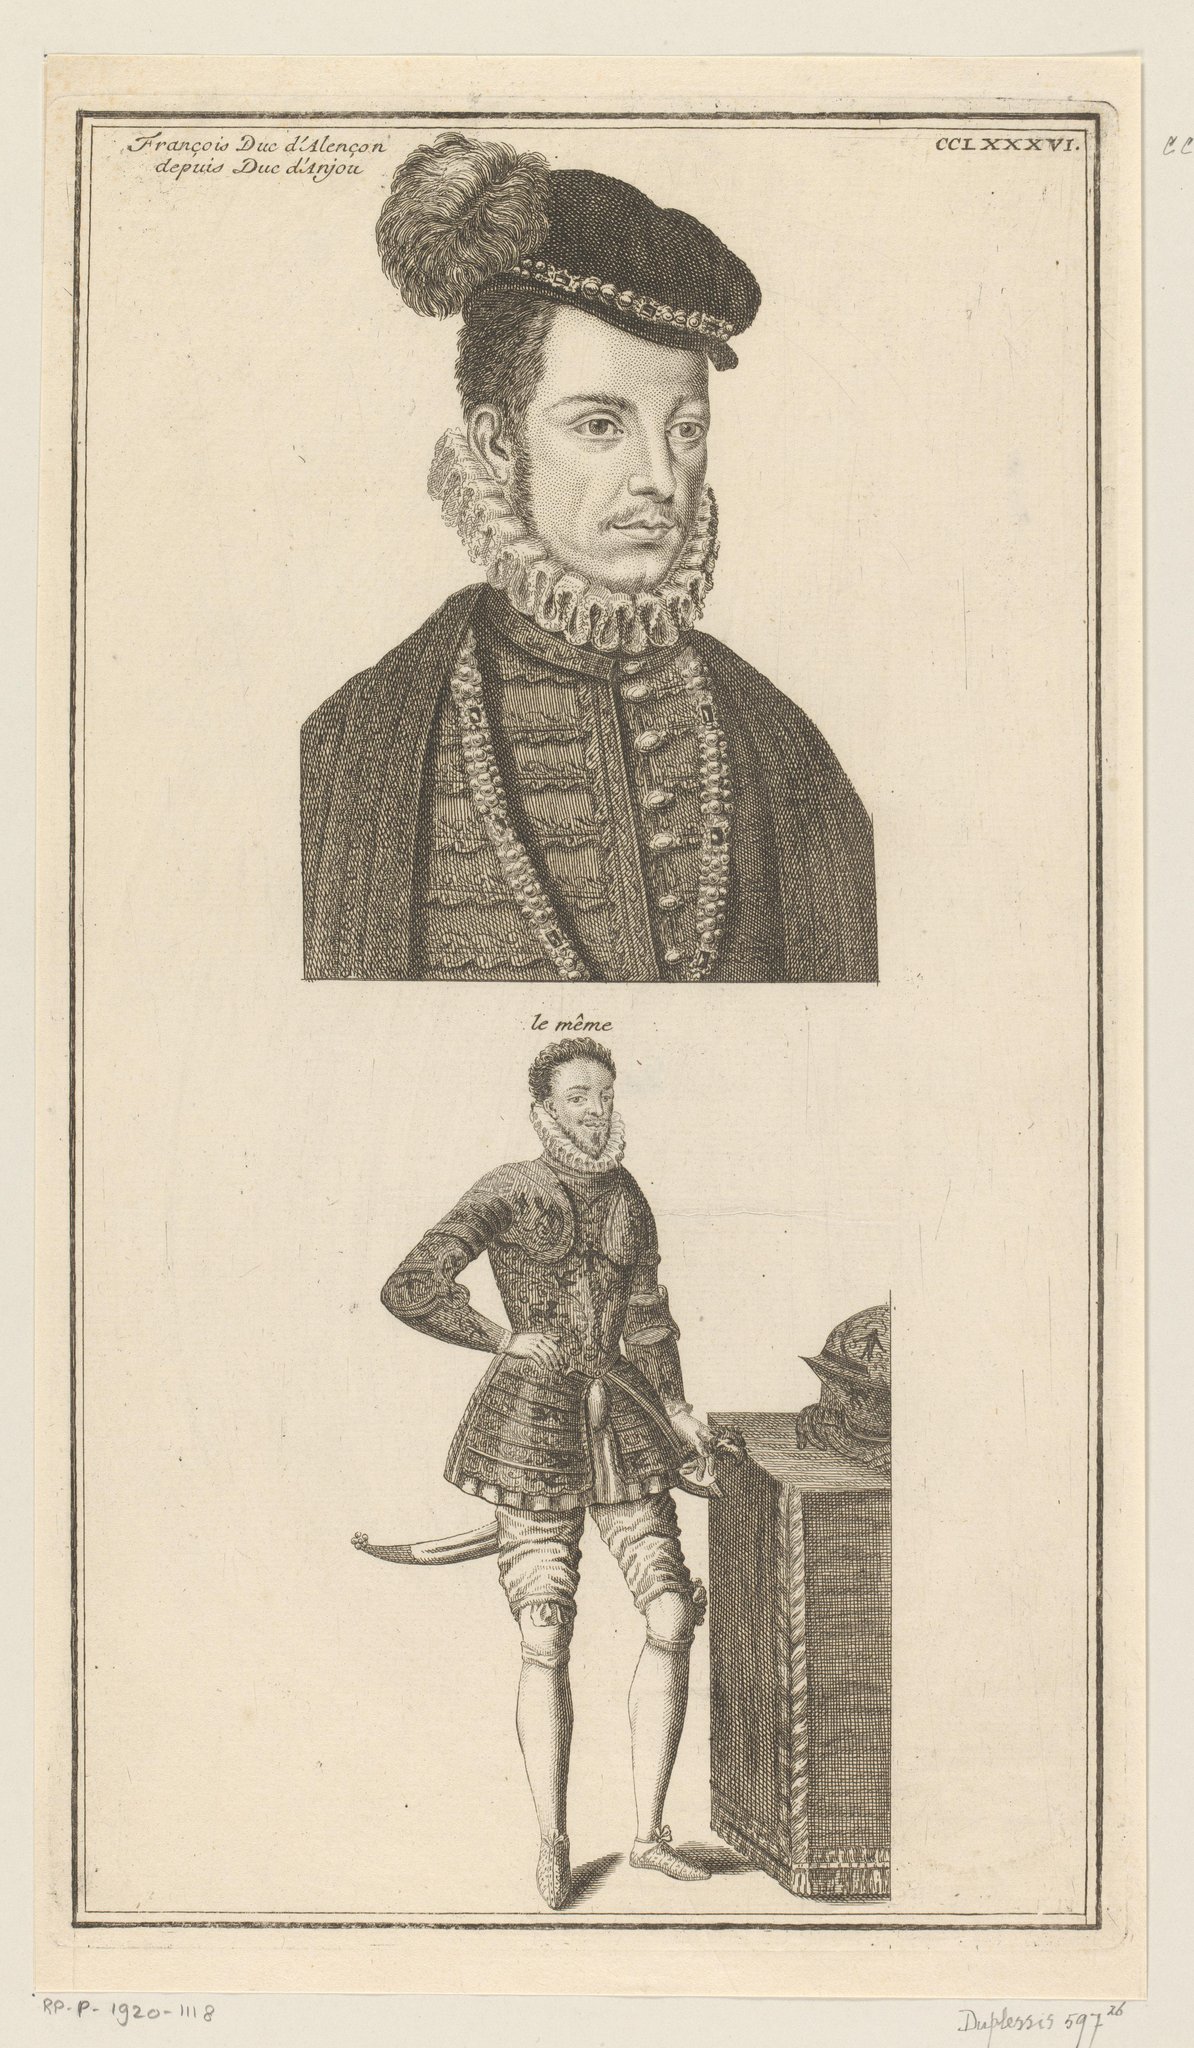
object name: book illustration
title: Portret van François-Hercule de Valois, hertog van Alençon en Anjou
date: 1750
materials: paper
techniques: etching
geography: london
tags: françois-hercule de valois (hertog van anjou), historical persons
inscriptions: collector's mark: Lugt 2228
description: Prent uit: Montfaucon, Bernard de. A collection of regal and ecclesiastical antiquities of France (...). Londen: William Innys, John en Paul Knapton, R. Manby en Henry Shute Cox, 1750, dl. 2. Prent voor het eerst, met andere nummering, verschenen in: Montfaucon, Bernard de. Les monumens de la Monarchie Françoise (...). Parijs: Julien-Michel Gandouin en Pierre-François Giffart, 1729-1733.